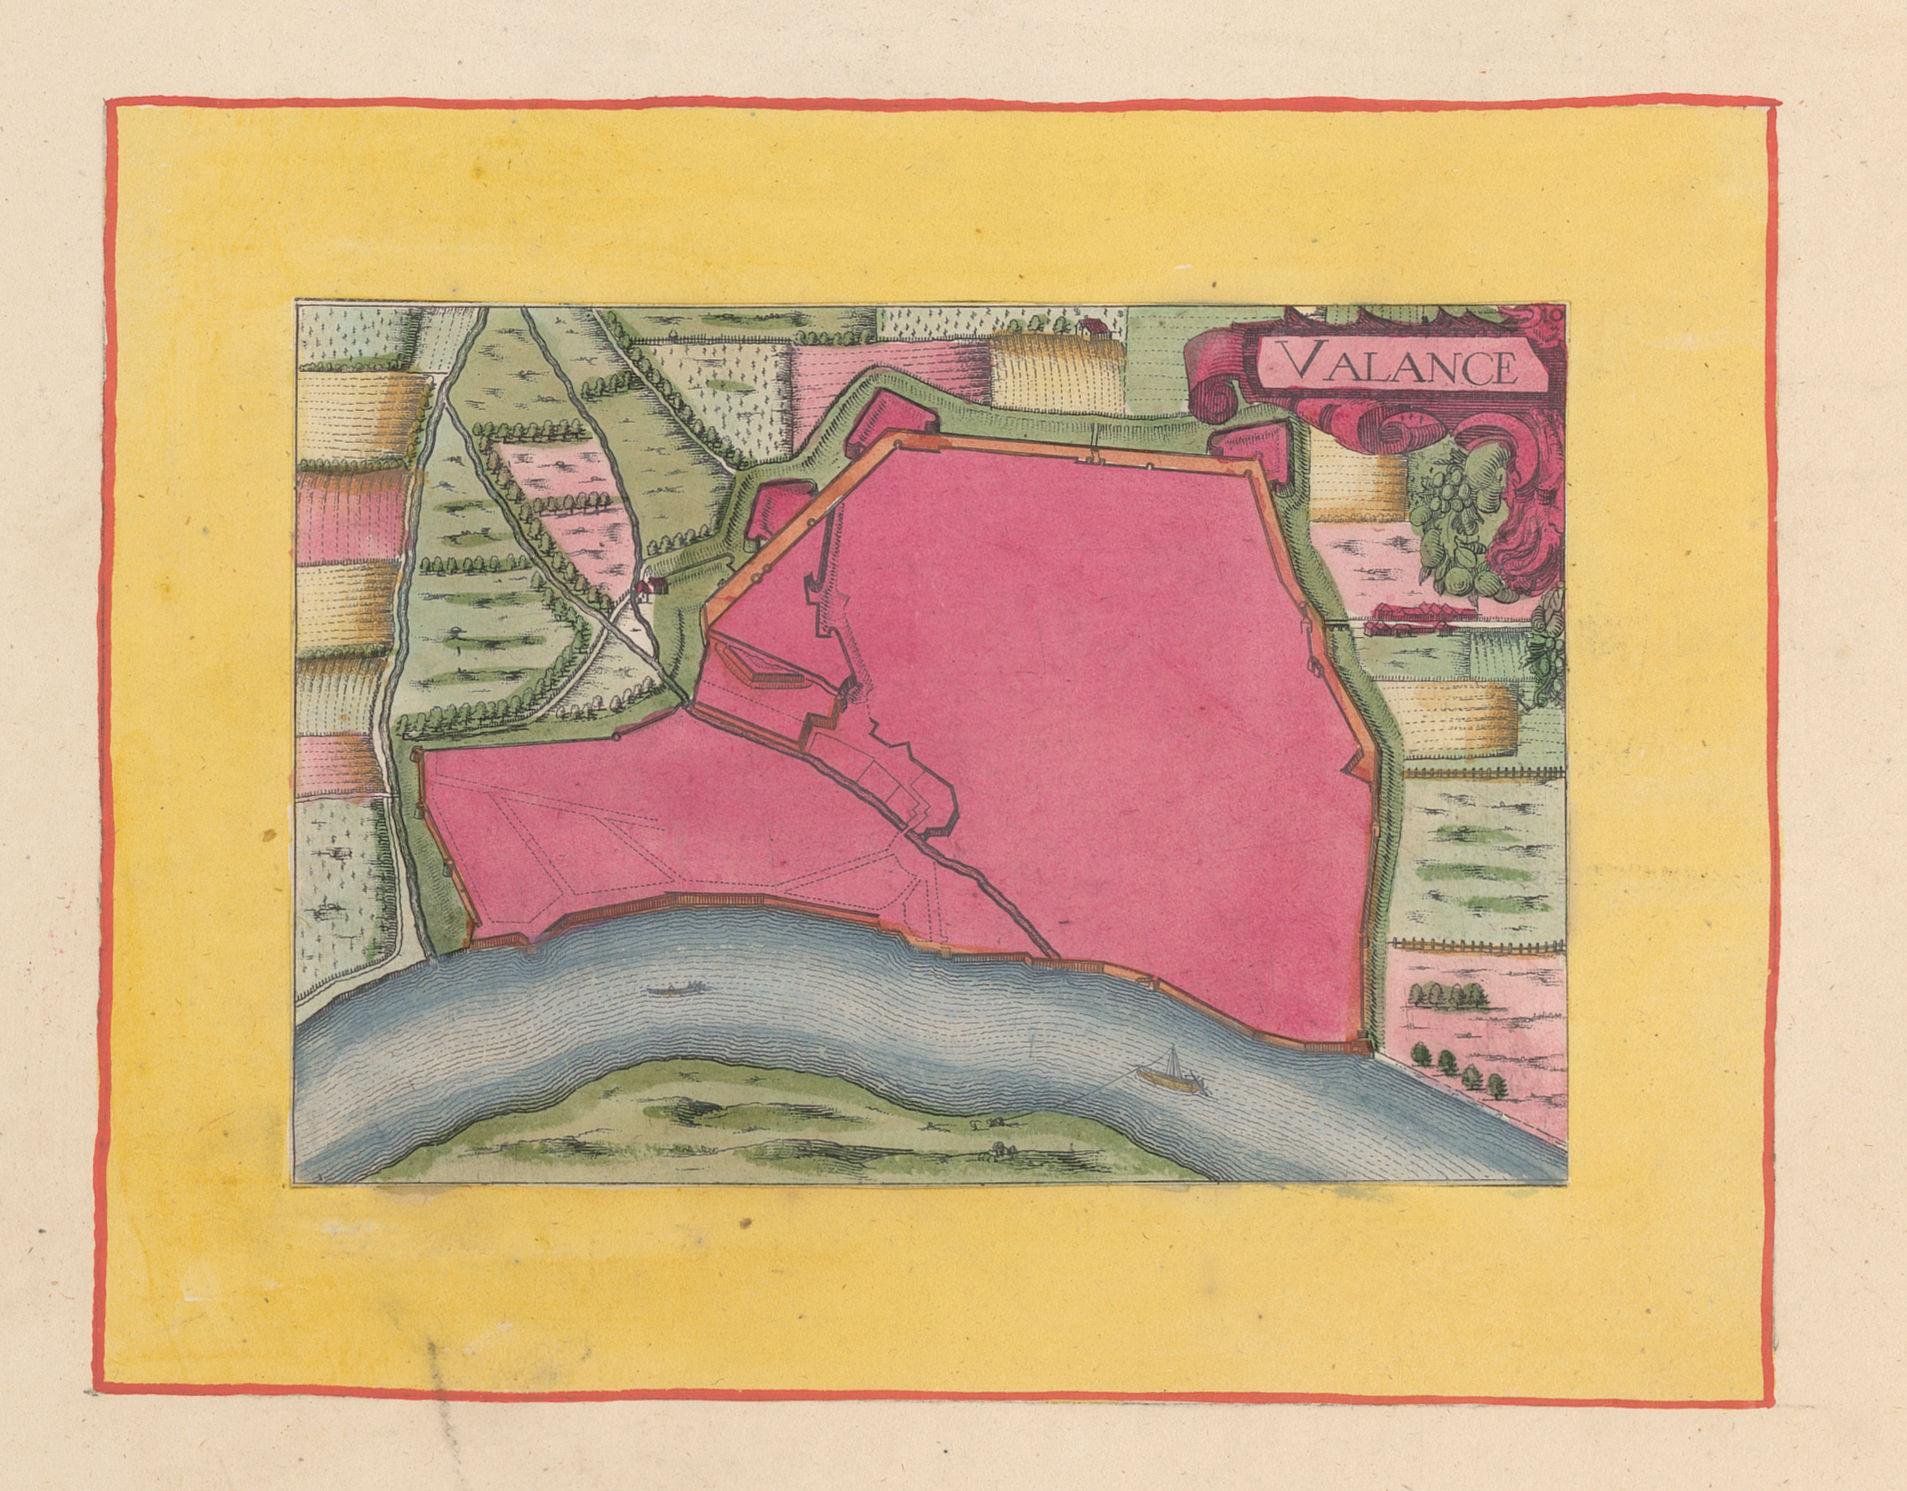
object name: print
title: Valance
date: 1638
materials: paper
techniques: engraving, hand coloring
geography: paris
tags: maps of cities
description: Prent uit: Tassin, Christophe. Les plans et profils de toutes les principales villes et lieux considérables de France (...). Parijs: Michel van Lochom, 1638, prent nummer 10 in het deel 'Dauphiné'.